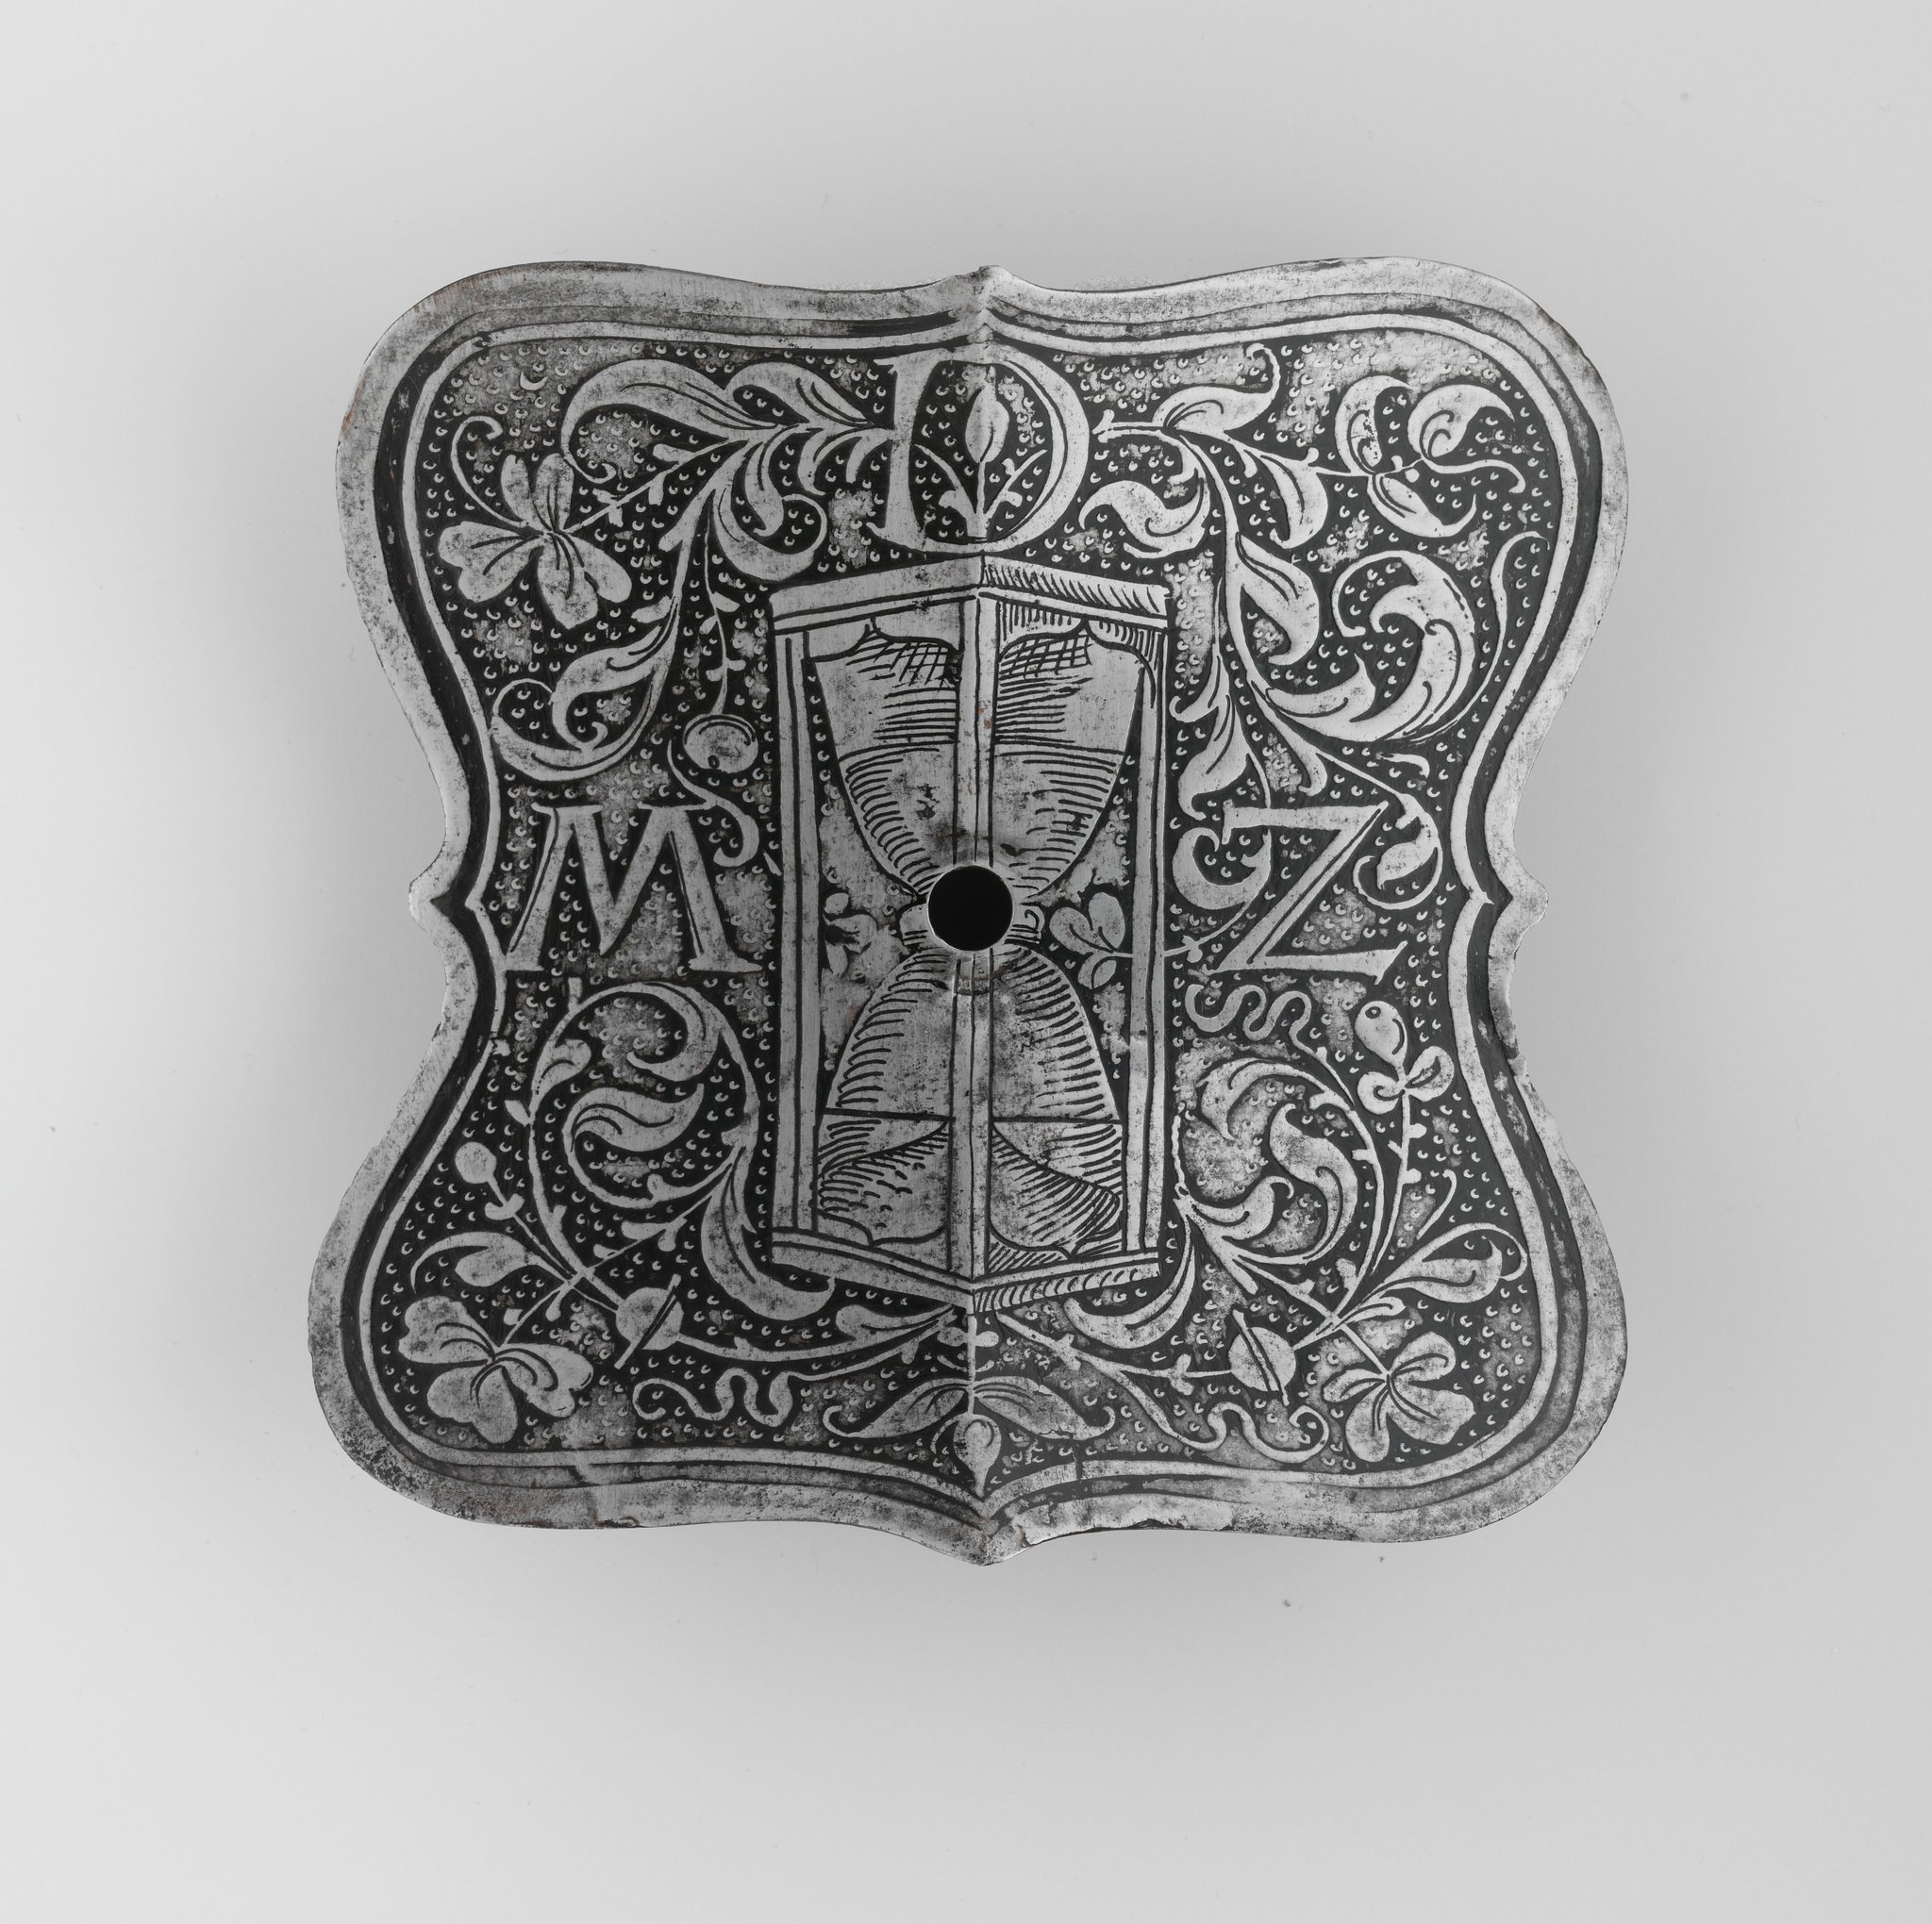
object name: escutcheon plate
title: Escutcheon Plate with the Device of Ottheinrich, Count Palatine of the Rhine (1502–1559)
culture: german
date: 1525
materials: steel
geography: germany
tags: hourglass